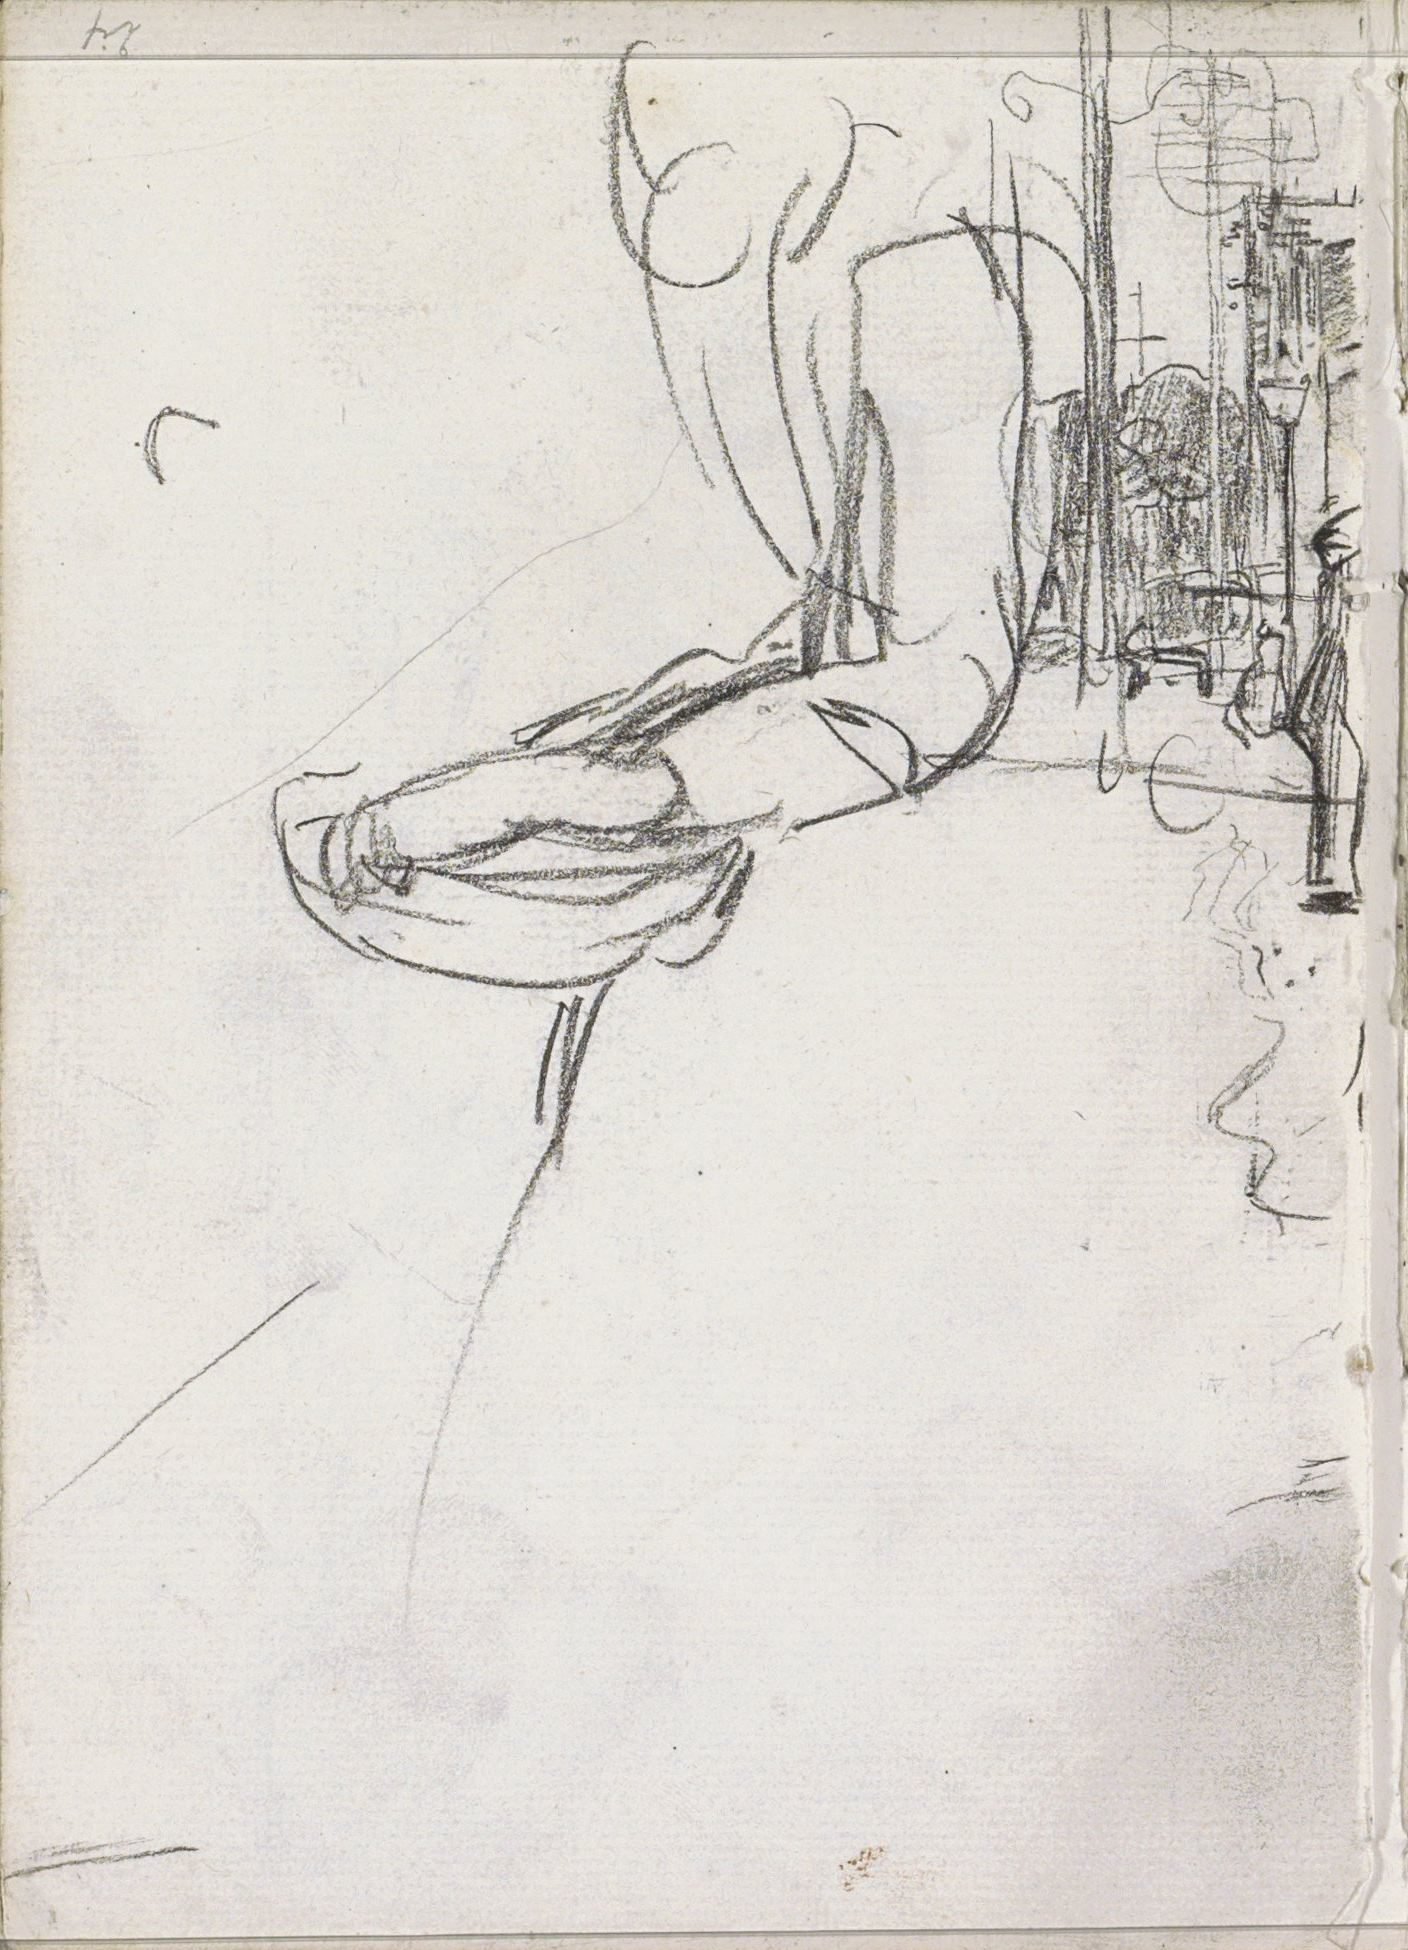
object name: sketchbook leaf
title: Straatgezicht en een vrouw met een kom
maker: isaac israels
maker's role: draughtsman, painter, print maker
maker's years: 1865-1934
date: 1886-1934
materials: chalk, paper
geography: amsterdam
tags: bowl, adult woman (+ sideview, profile), street (+ city(-scape) with figures, staffage)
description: Blad 19 verso uit schetsboek LV met 21 bladen.